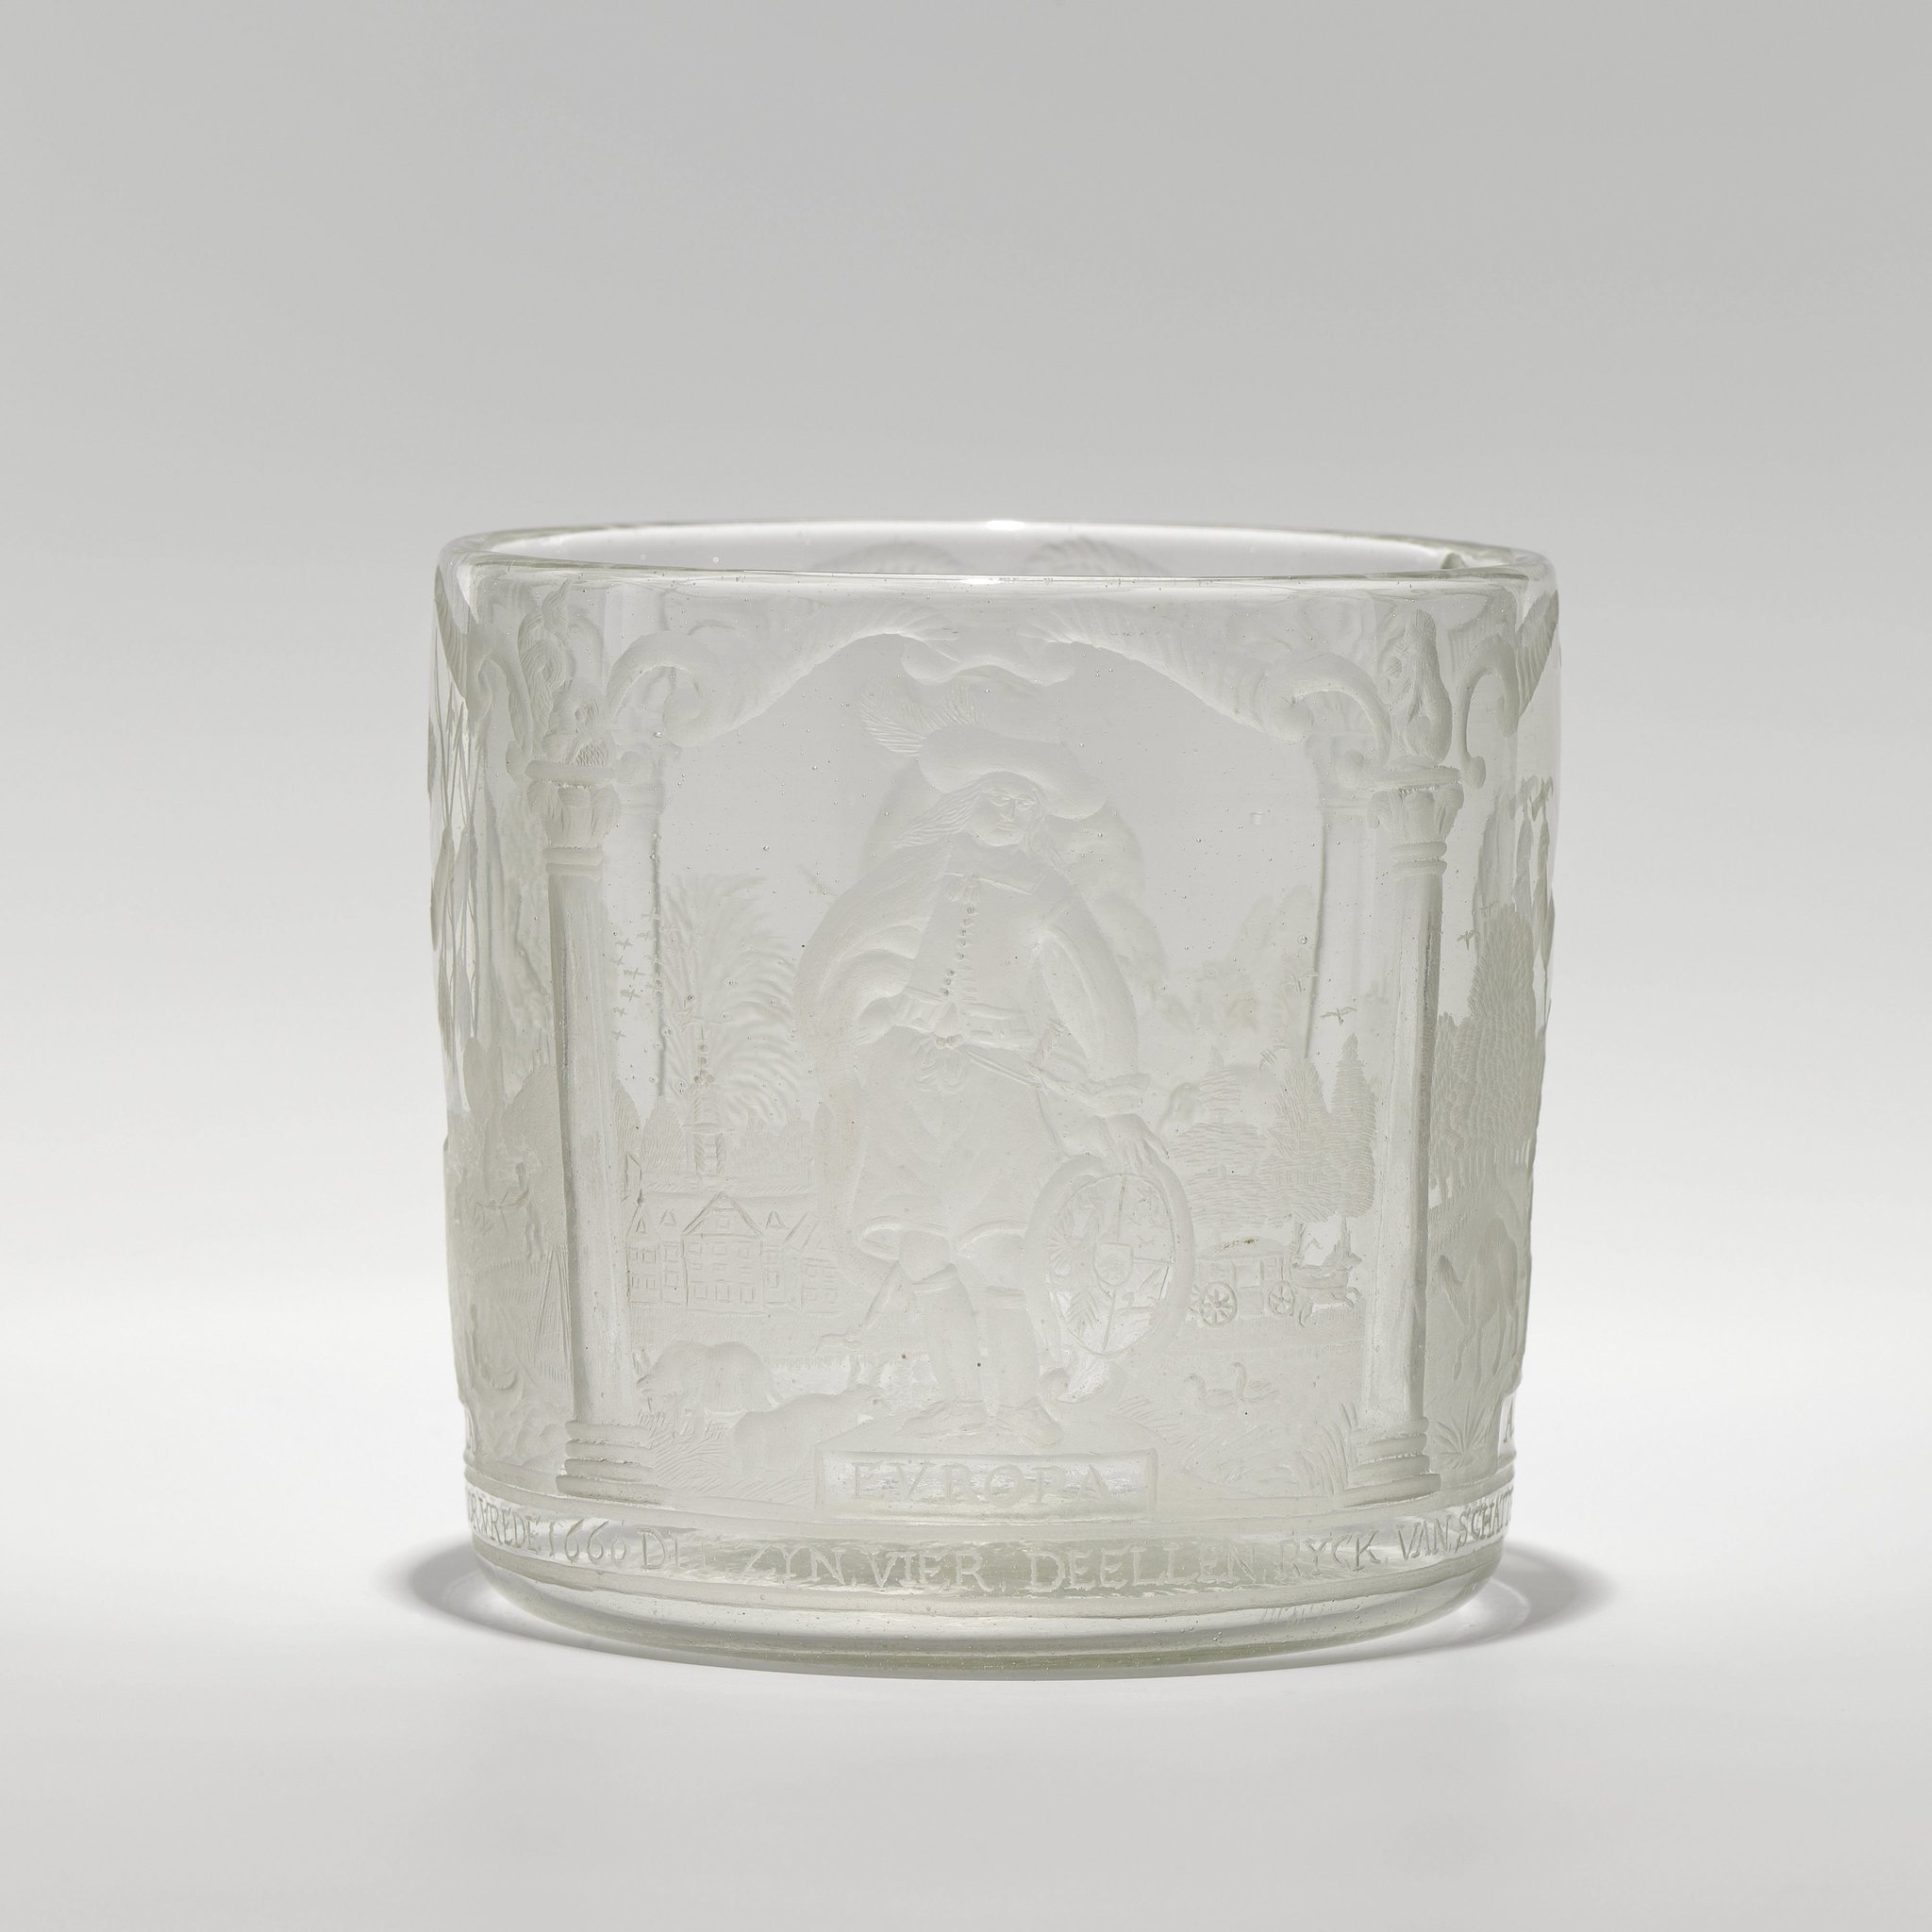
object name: cup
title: Beker met personificaties van de vier werelddelen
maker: Anonymous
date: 1660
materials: glass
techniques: façon de venise, glassblowing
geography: northern netherlands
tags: amsterdam, mayor, joan huydecoper van maarseveen (i), america represented allegorically; 'america' (ripa), indigenous peoples of north america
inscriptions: inscription: ‘EUROPA; ASIA; AFRICA; AMERICA’, inscription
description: Ingestoken bodem. Cilindrisch lichaam. Op de het lichaam zijn de vier werelddelen weergegeven. Europa wordt gepersonificeerd door de Amsterdamse burgemeester Joan Huydecoper (1599-1661), met een gevederde hoed, staand voor zijn buitenhuis Goudesteijn, in een landschap met koeien en zwanen. Zijn linkerhand rust op een ovaal schild met zijn wapen, en hij staat op een plint met de inscriptie EUROPA. Op de achtergrond rechts een rijtuig, getrokken door paarden. Azië wordt gepersonificeerd door een arabier met tulband en een staf in zijn rechterhand. Hij staat op een plint met de inscriptie ASIA in een landschap met bomen, een aap en een dromedaris. Afrika wordt gepersonificeerd door een krijger in een dierenhuid, gezien van achteren, in een landschap met palmen, een olifant, een liggende kameel, een lopende vogel en bergen. In zijn rechterhand houdt hij een pijl, in zijn linkerhand een boog, op zijn rug hangt een pijlenkoken. Hij staat op een plint met de inscriptie AFRICA. Amerika wordt gepersonificeerd door een indiaan met een hoofdtooi, een pijlenkoker op de rug, pijl en boog in de linkerhand en een papegaai in de rechterhand. Hij staat op een plint met de inscriptie AMERICA aan de oever van een rivier in een landschap met bomen, een aap, een vos en twee honden (?). Op de rivier een man in een roeiboot, aan de overzijde van de rivier zijn twee mannen bezig met een braadspit. De vier scènes zijn van elkaar gescheiden door middel van zuilen, die met elkaar verbonden zijn door voluten. Op de kapitelen van de zuilen, te beginnen met de zuil ter linkerzijde van Europa, zitten een pauw, een aap, een pelikaan en een papegaai. Onder de voorstellingen een doorlopende band met de inscriptie: DIT ZYN VIER DEELLEN RYCK VAN SCHATTEN VOLCK EN STEDE: HAER HEIL BESTAET IN RUST HET AARDTRIJCK BLOEIT DOOR VREDE 1660.